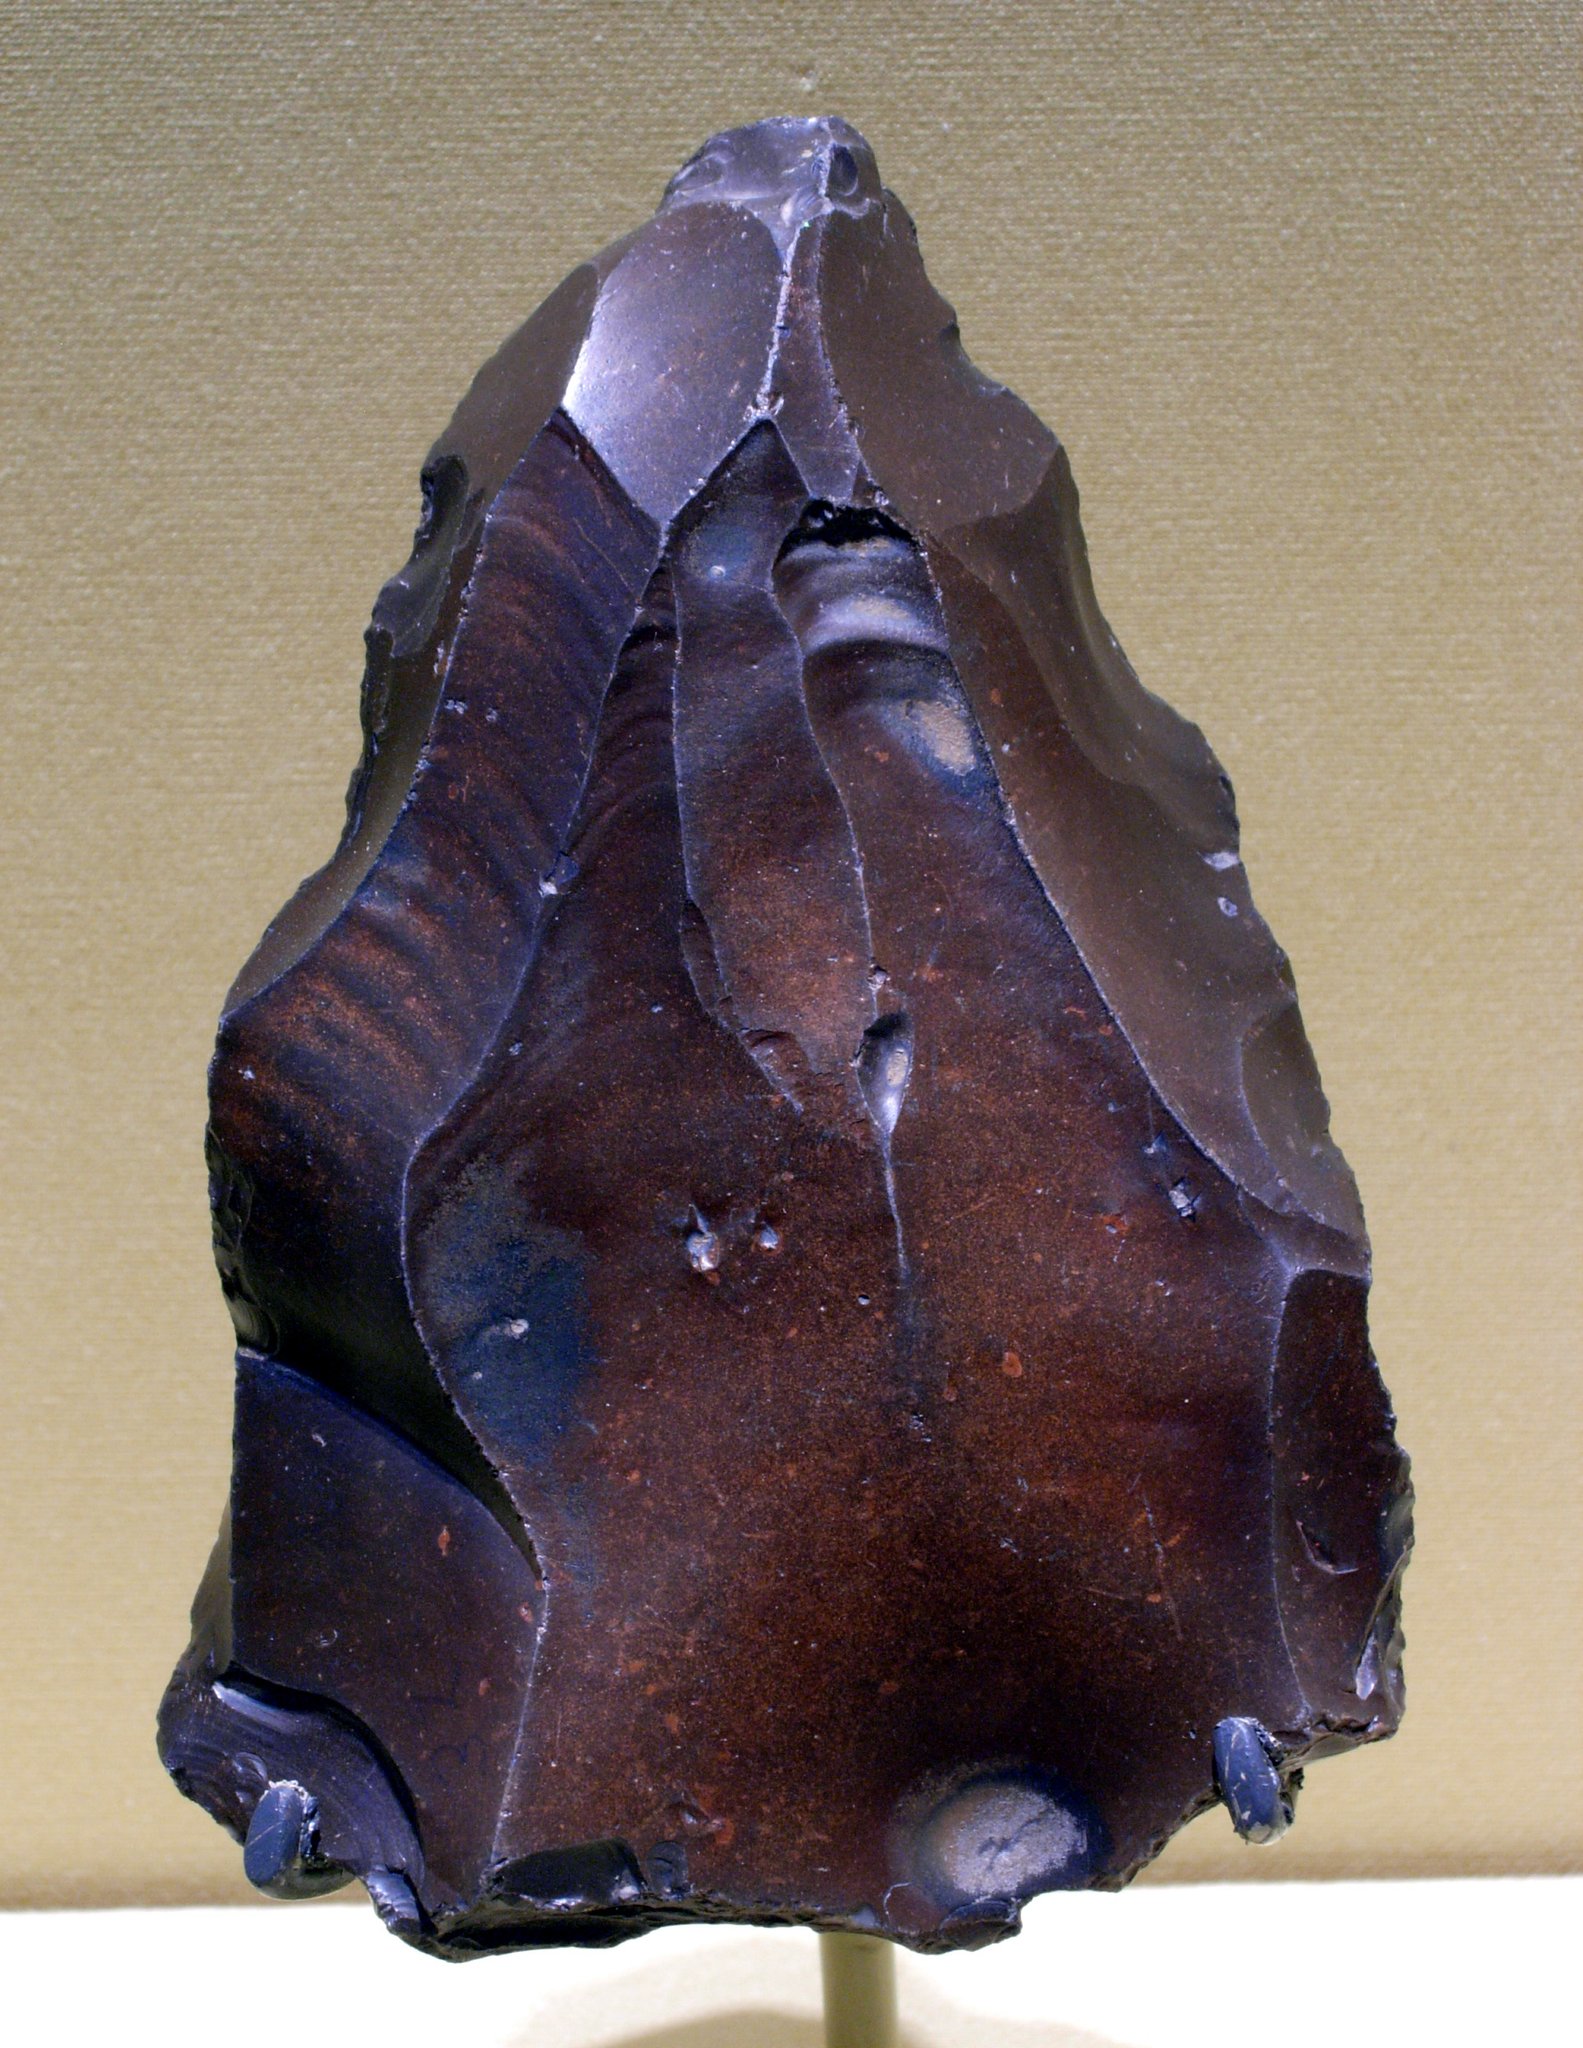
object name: core, levallois, nubian a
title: Levallois Core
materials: stone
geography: egypt